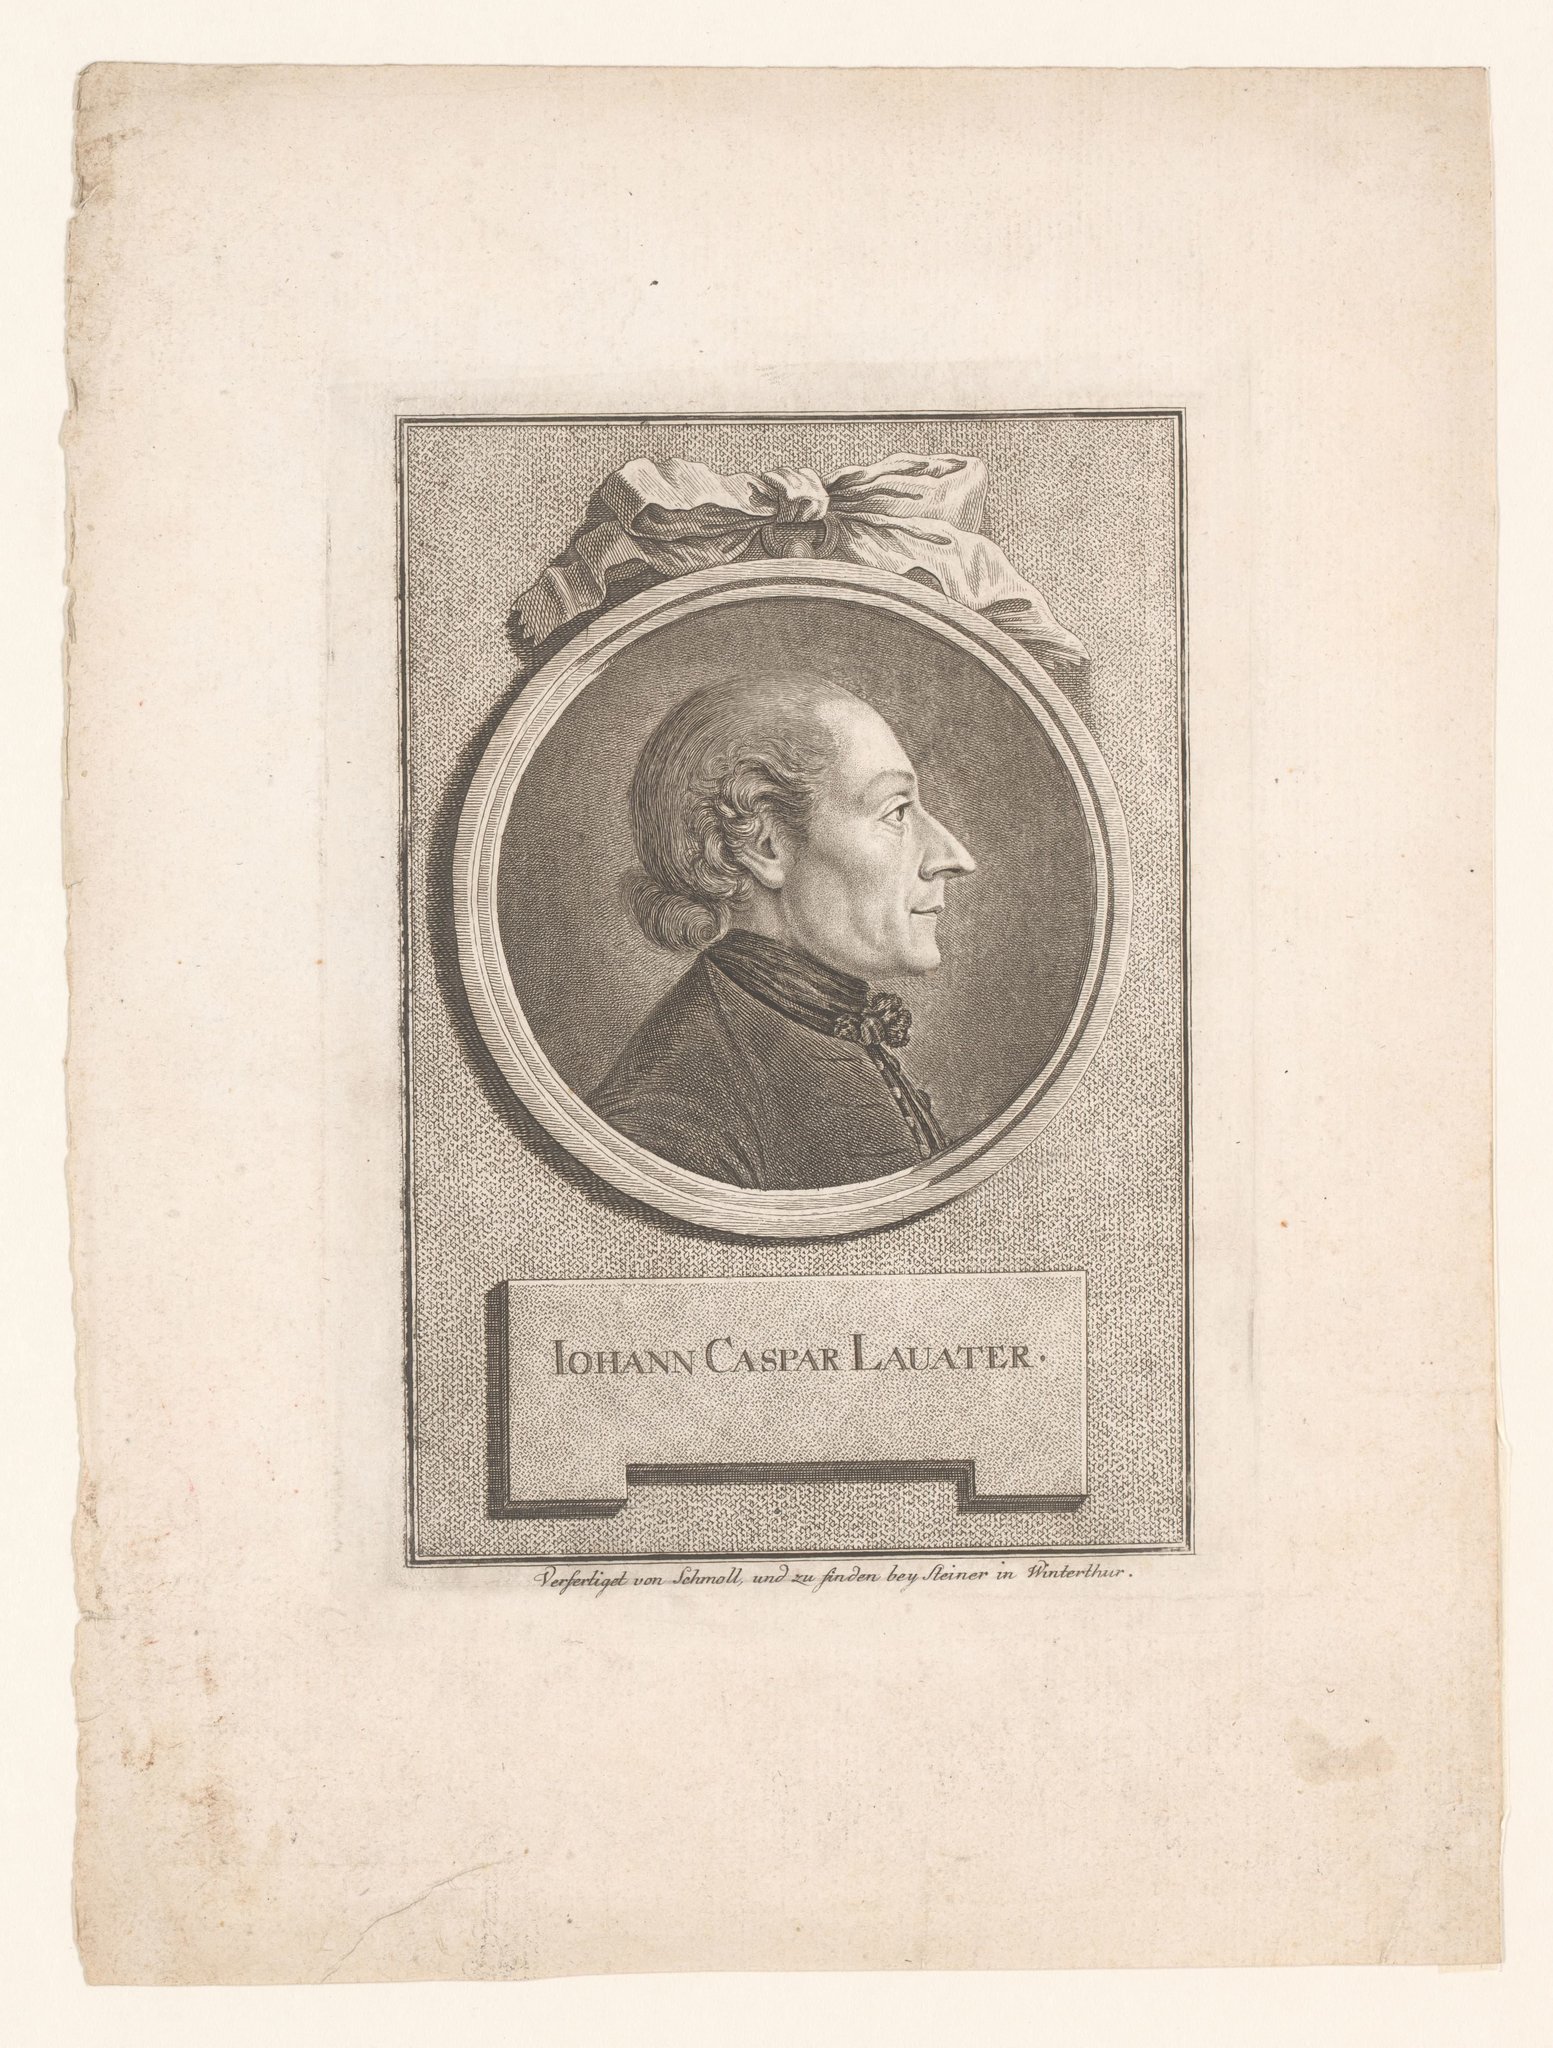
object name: print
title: Portret van Johann Caspar Lavater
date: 1700-1785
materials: paper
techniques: etching, engraving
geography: winterthur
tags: johann caspar lavater, historical persons